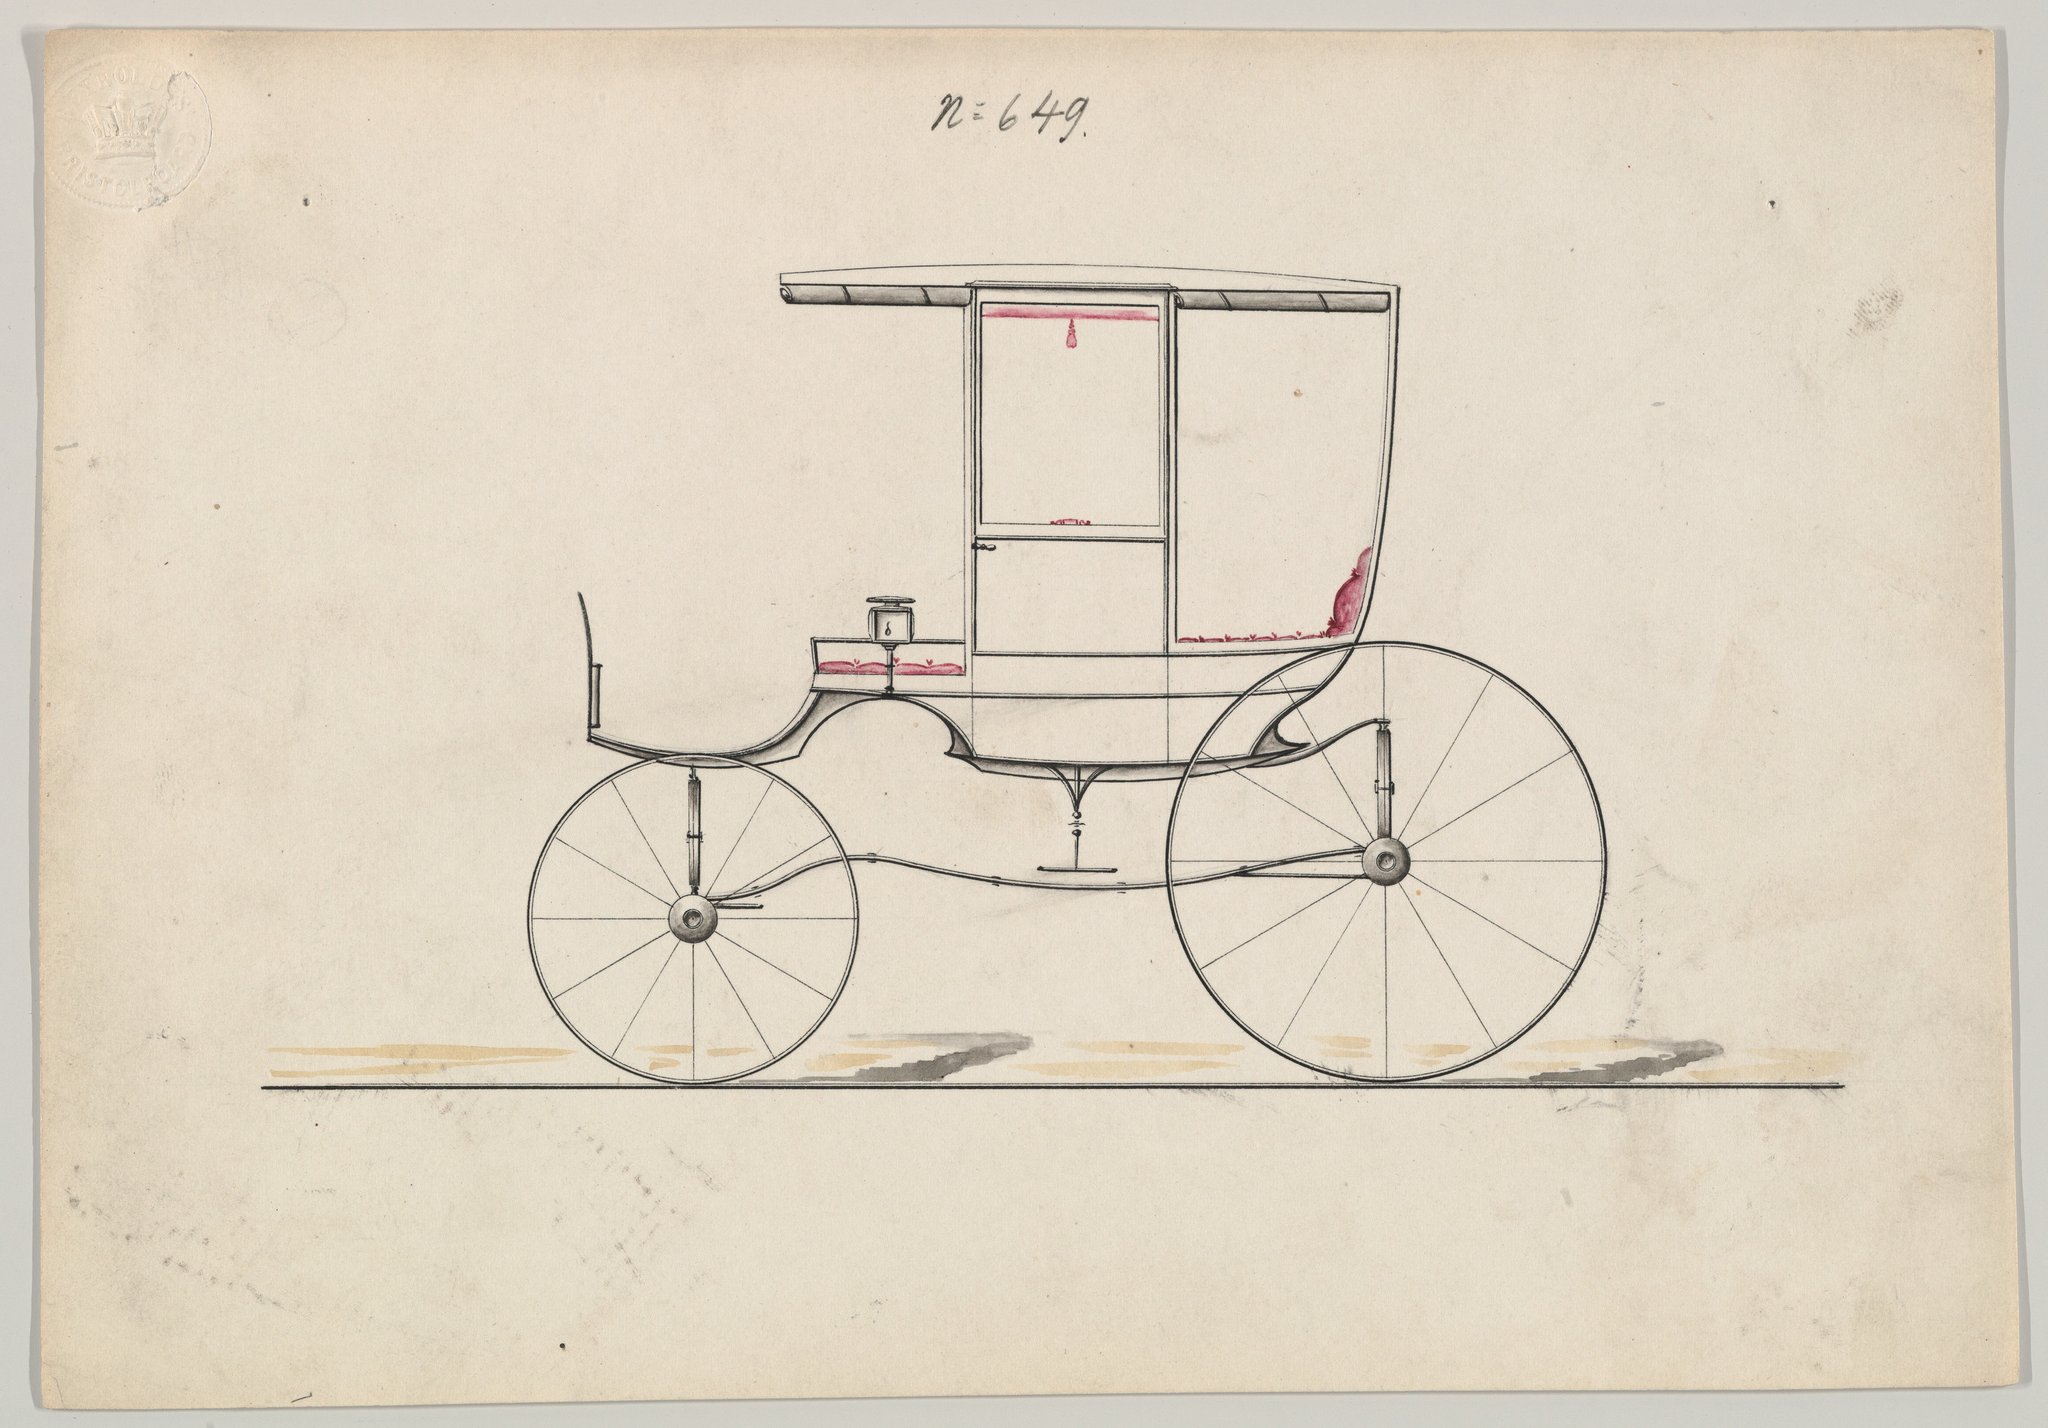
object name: drawing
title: Rockaway #649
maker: brewster & co.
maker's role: manufacturer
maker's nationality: american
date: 1865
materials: gouache, ink, watercolor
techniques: pen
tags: carriages